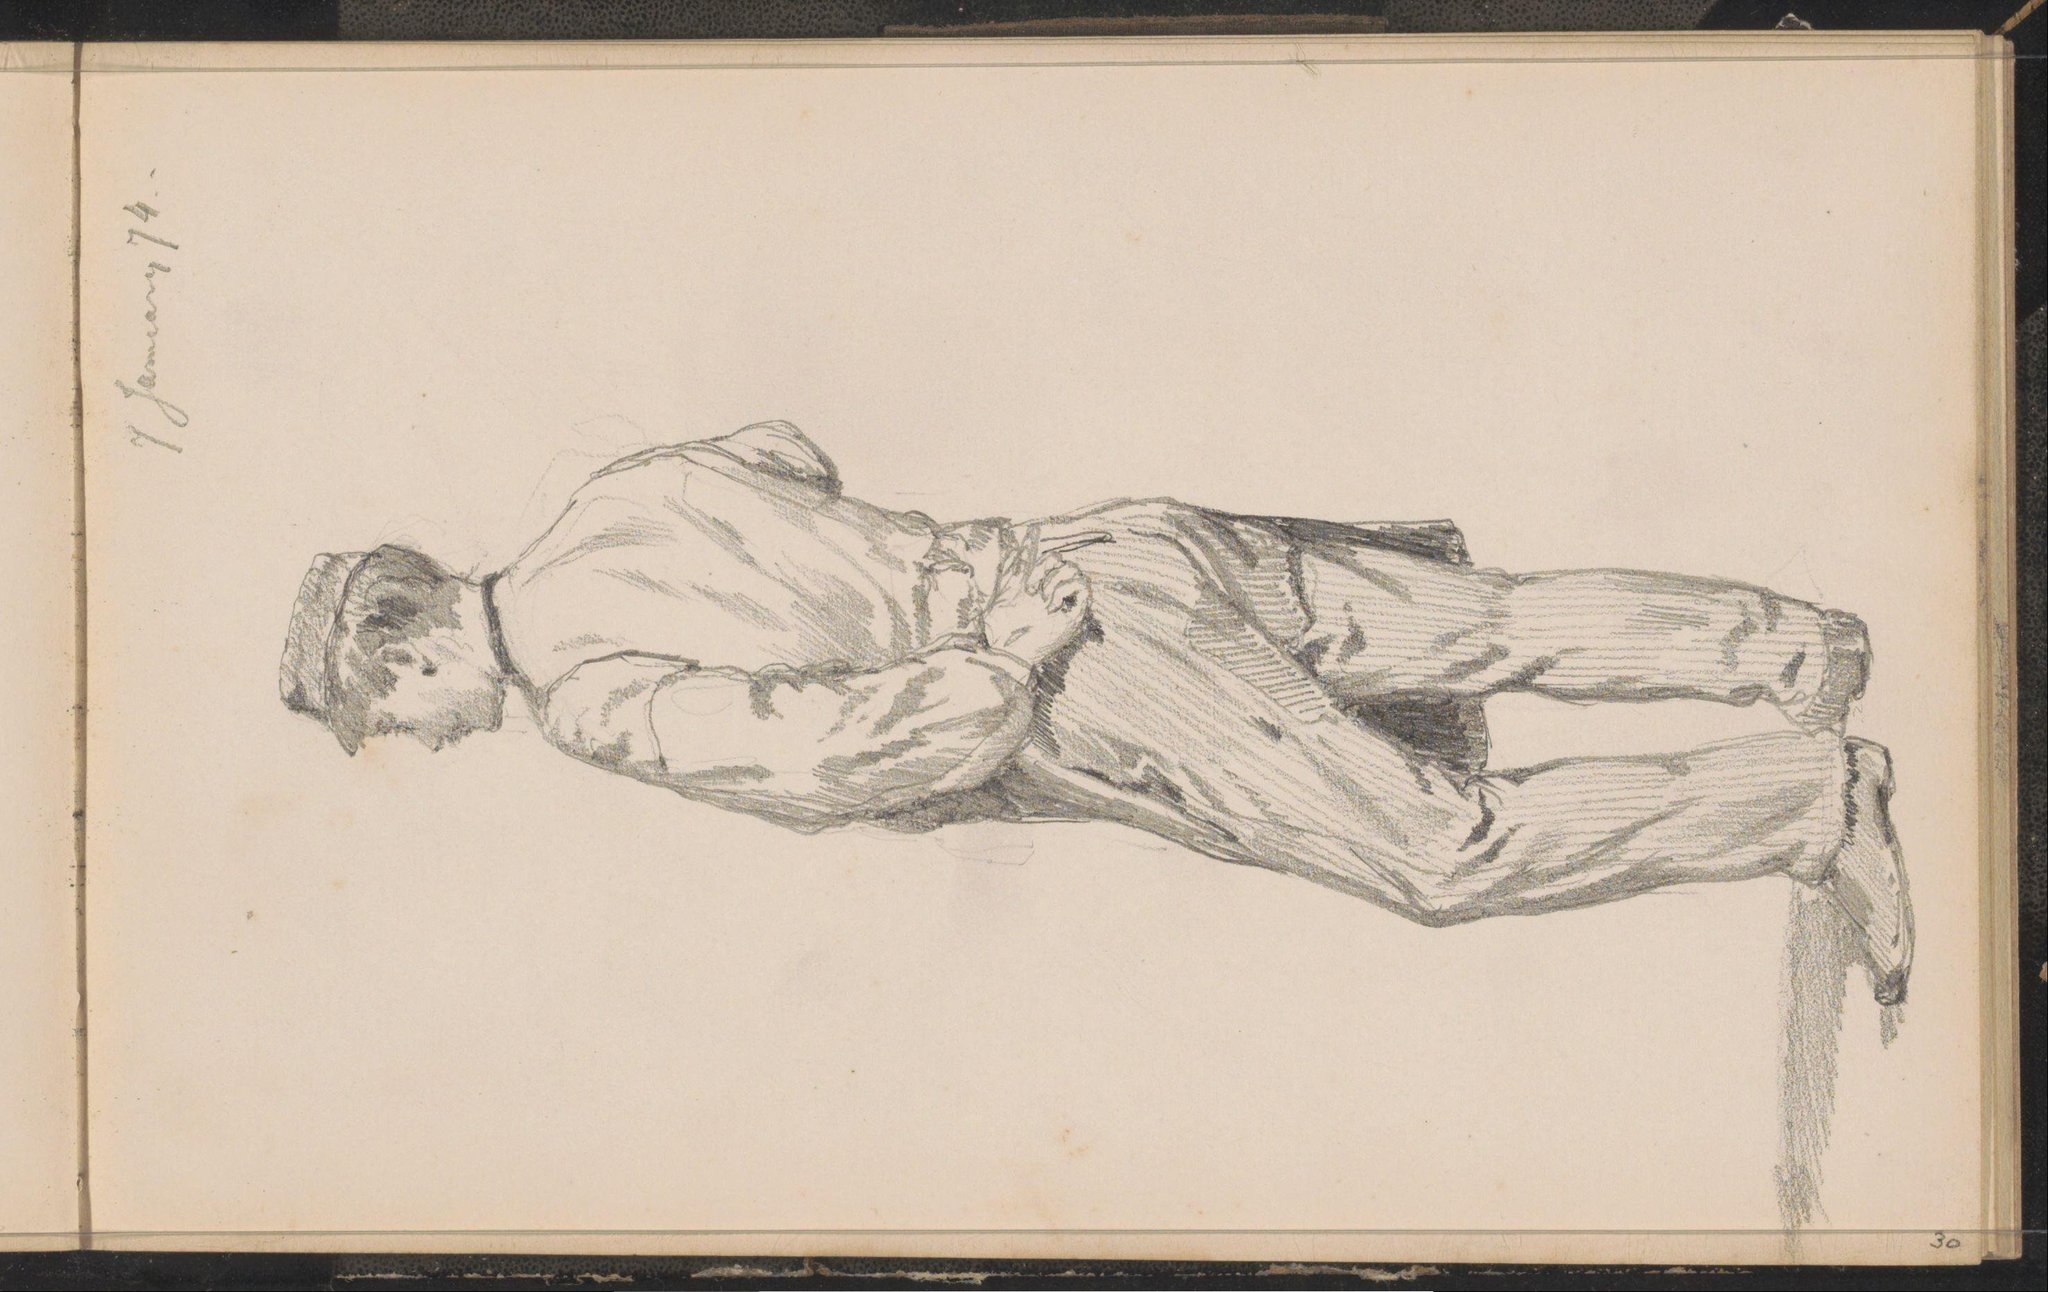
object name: sketchbook leaf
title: Man met een pet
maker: cornelis springer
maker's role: draughtsman, painter, print maker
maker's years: 1817-1891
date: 1874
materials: paper, pencil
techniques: stumping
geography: netherlands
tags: standing figure (+ sideview, profile)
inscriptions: date: ‘7 January 74’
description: Man met een pet en een schort, in profiel naar links. Blad 30 uit een schetsboek met 46 bladen.